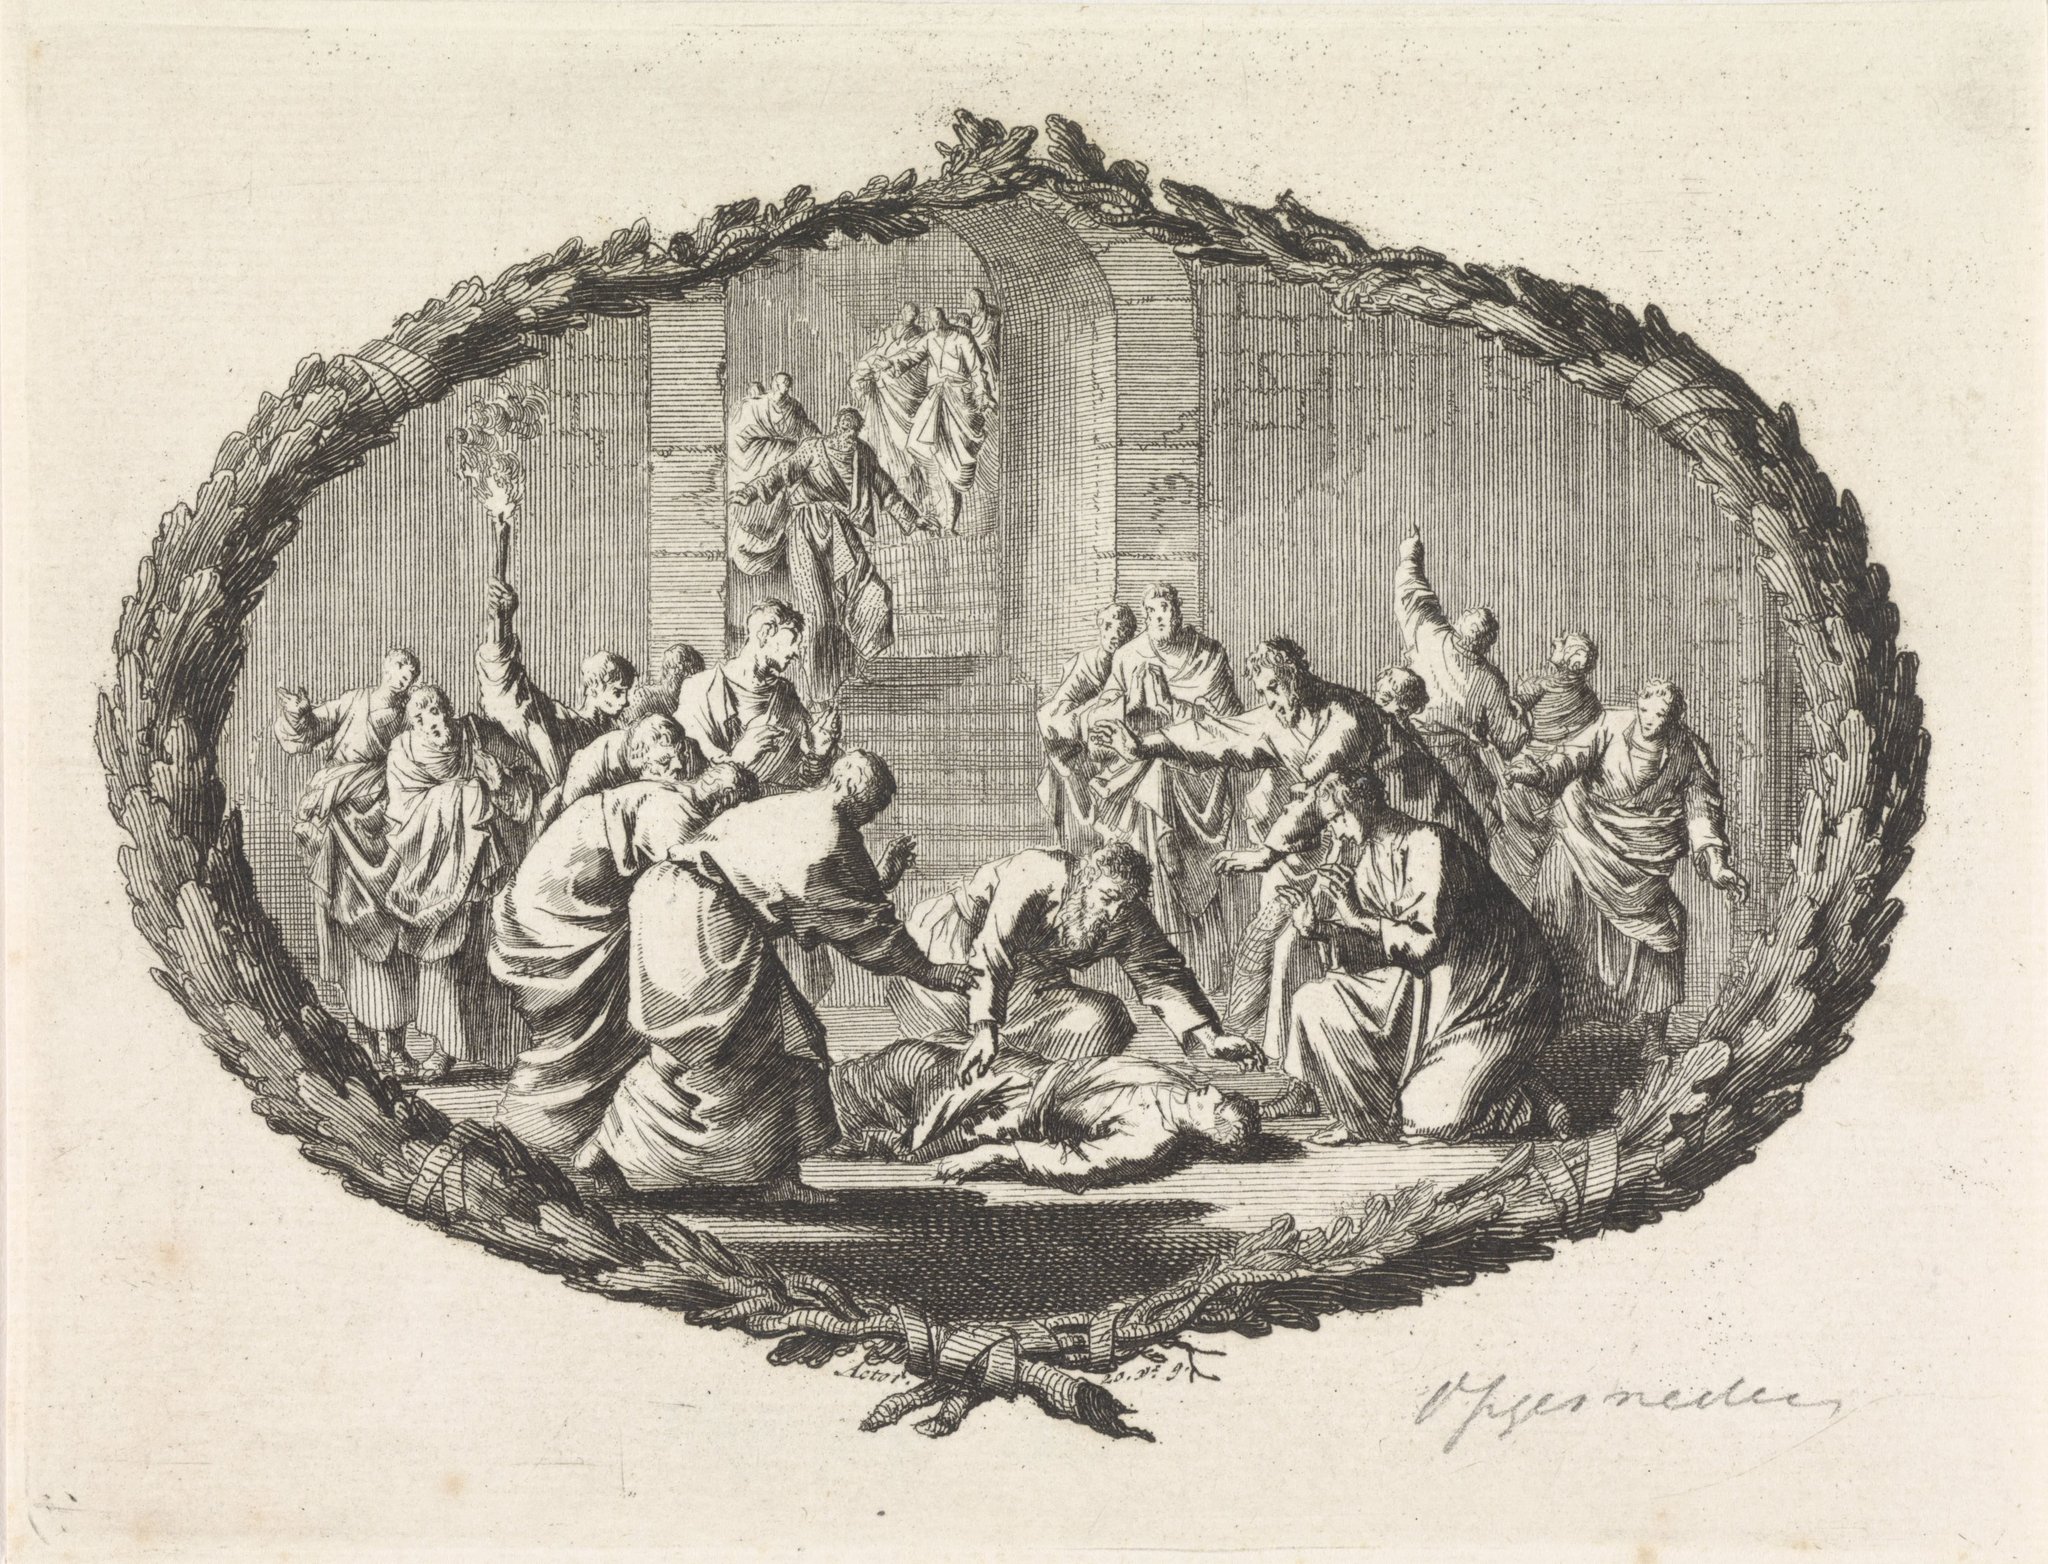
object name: print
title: Paulus ontfermt zich over de gevallen Eutychus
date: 1700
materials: paper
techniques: etching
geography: amsterdam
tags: ornament ~ cartouche, eutychus is raised from the dead by paul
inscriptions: collector's mark: Lugt 2228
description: Waarschijnlijk boekillustratie voor David Martin. Historie des Ouden en Nieuwen Testaments, verrykt met meer dan vierhonderd printverbeeldingen. Deel II. Amsterdam: Pieter Mortier, 1700, p. 110.